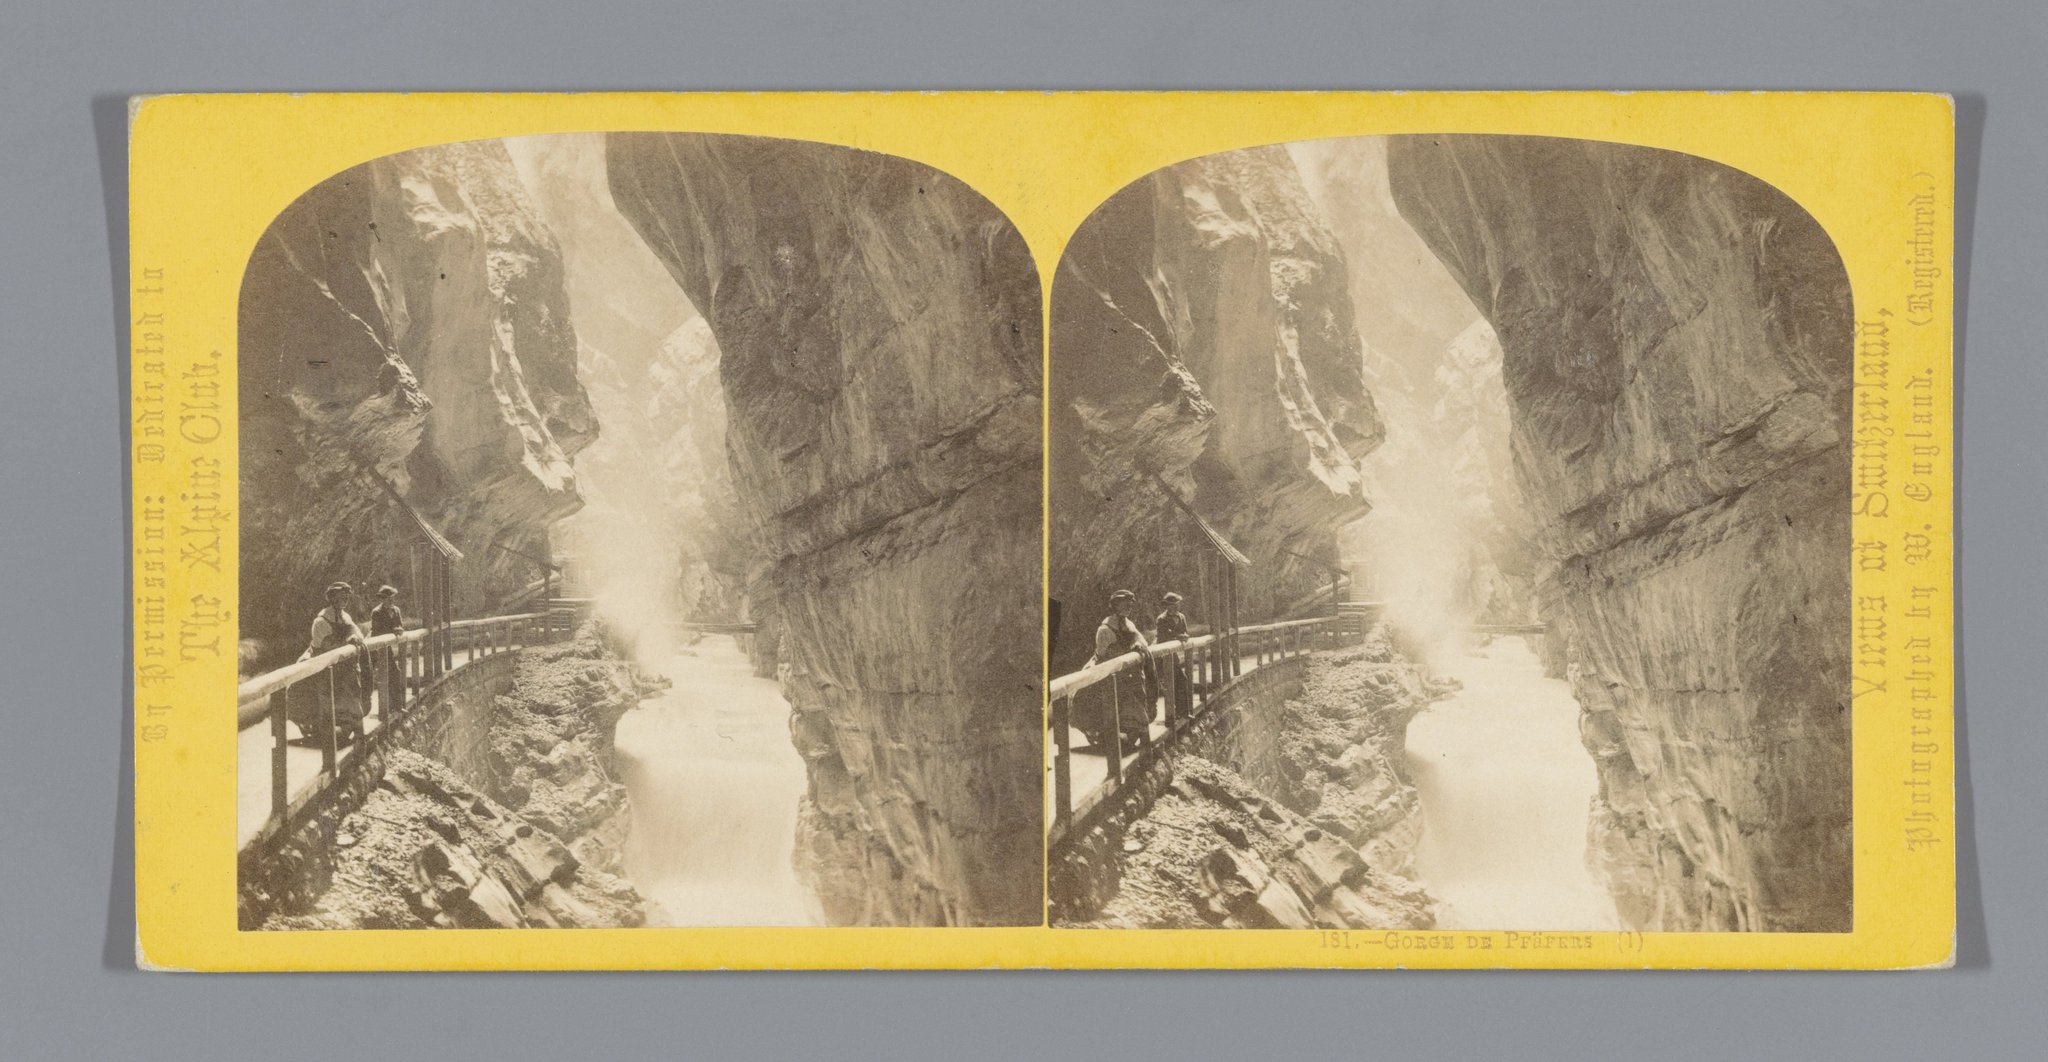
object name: stereograph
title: Gezicht op de Taminakloof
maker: william england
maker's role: fotograaf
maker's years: 1816-1896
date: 1850-1880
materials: cardboard, photographic support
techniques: albumen print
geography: taminakloof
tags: ravine, chasm, abyss, canyon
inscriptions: number: ‘181.’, inscription: ‘Views of Switzerland, photographed by W. England. (Registered) Under the Special Patronage of the Alpine Club.’